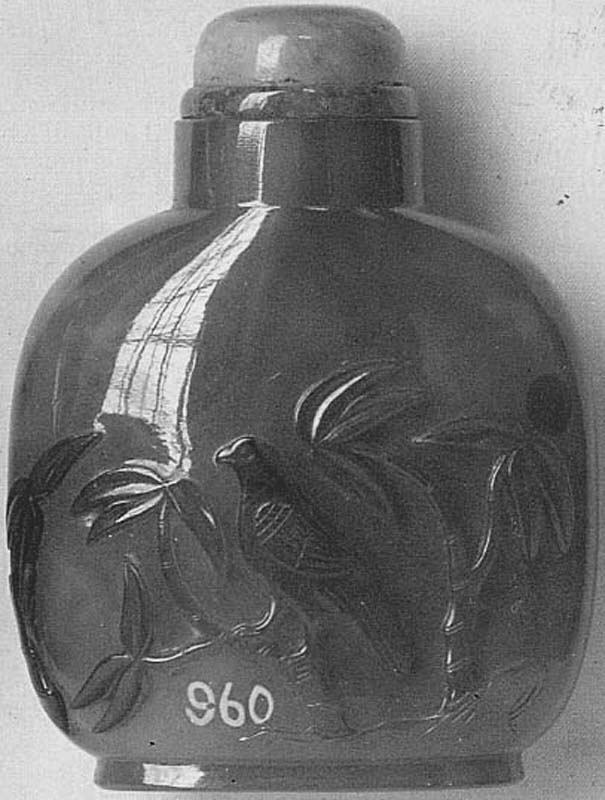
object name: snuff bottle with stopper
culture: chinese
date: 1701-1900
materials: stone, jade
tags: birds